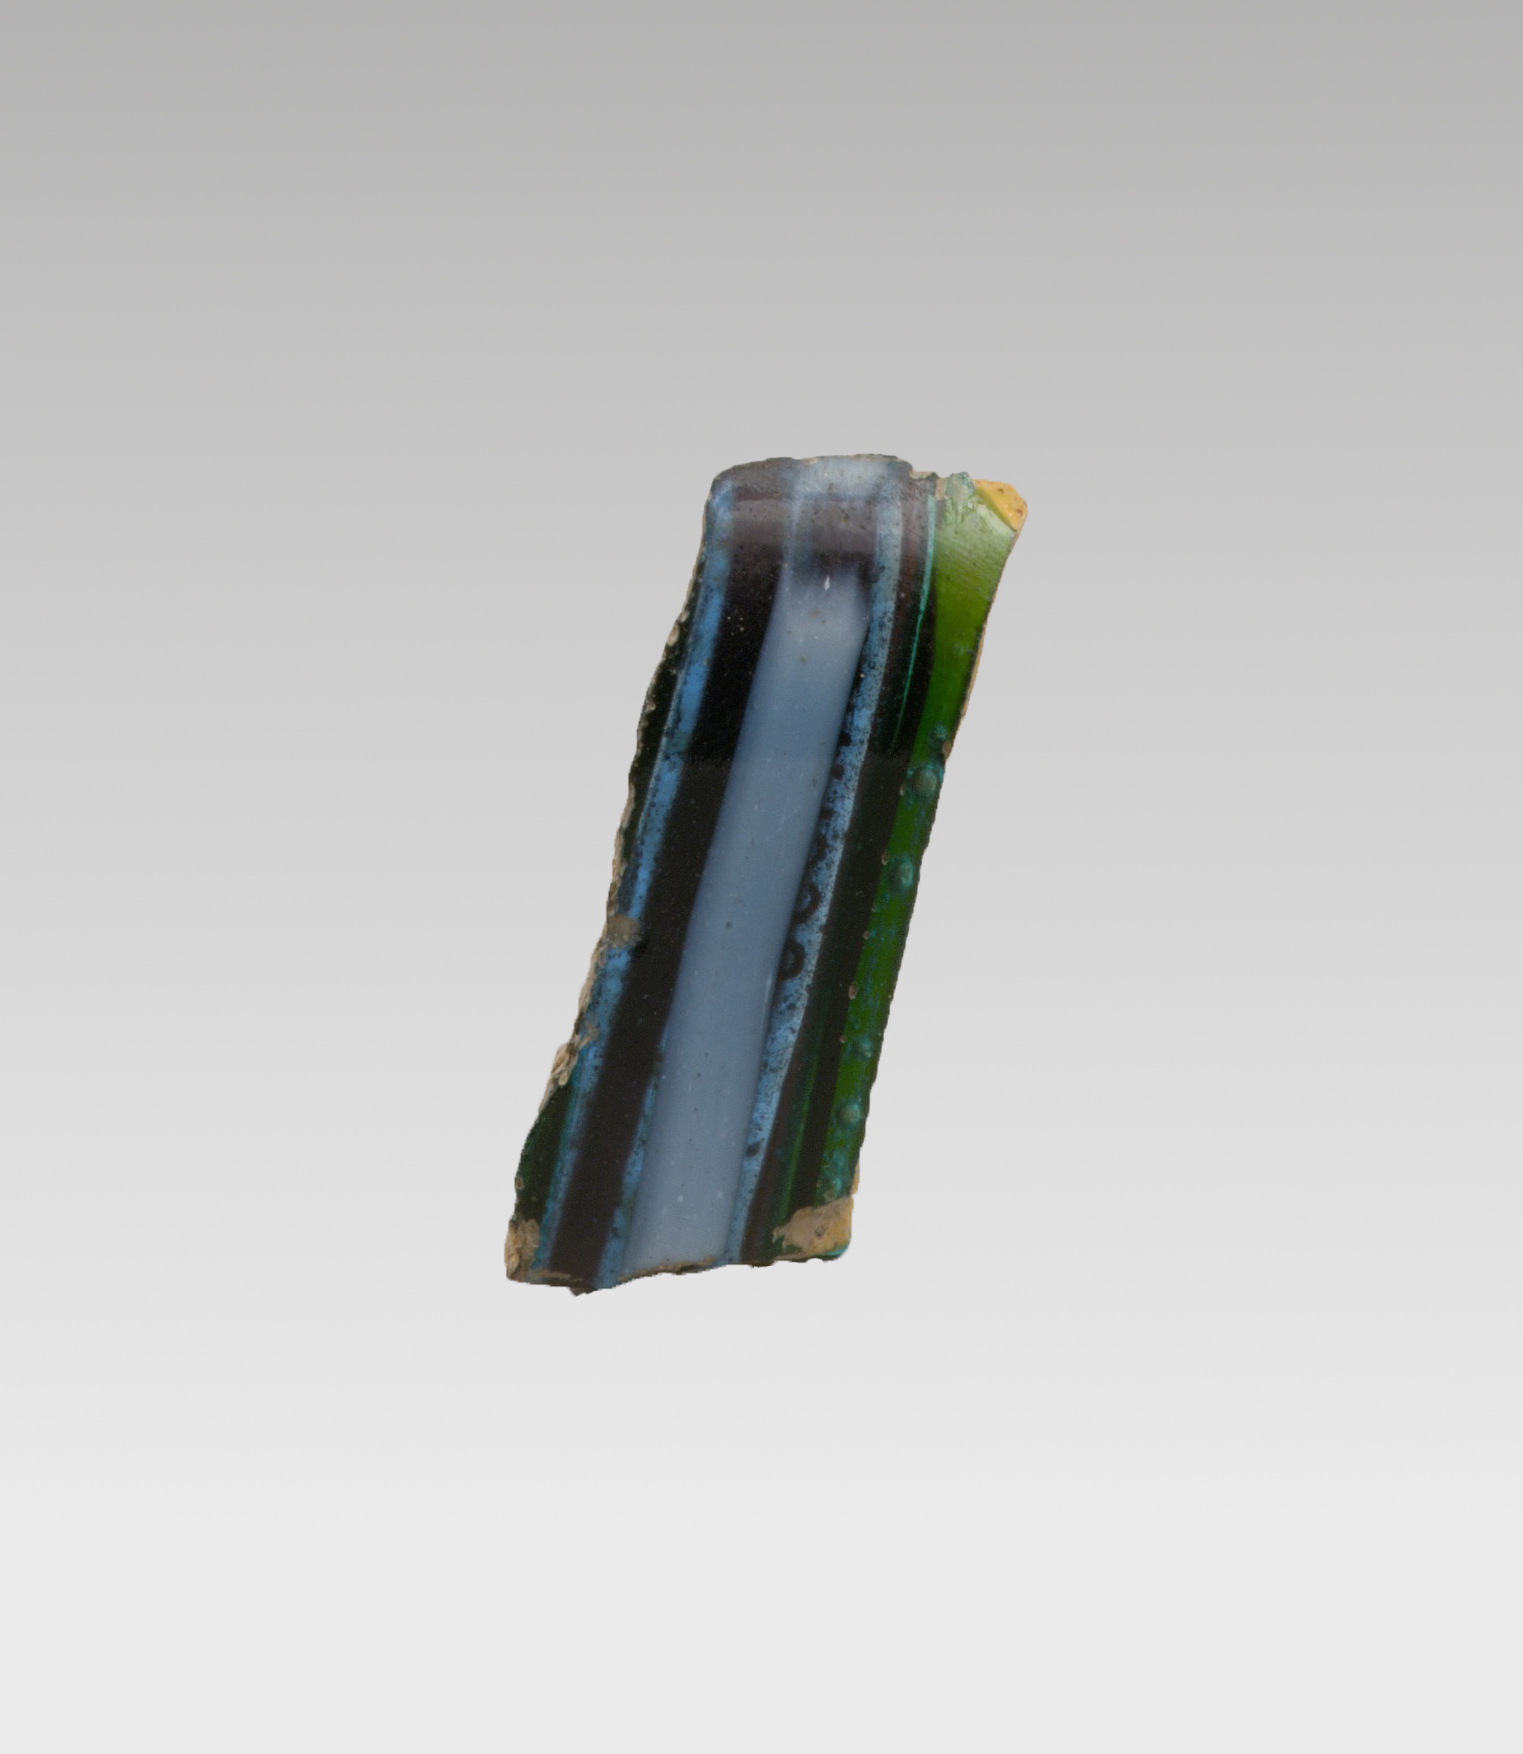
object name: fragment, mosaic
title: Glass mosaic fragment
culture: roman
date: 34 BCE-33 CE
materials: glass